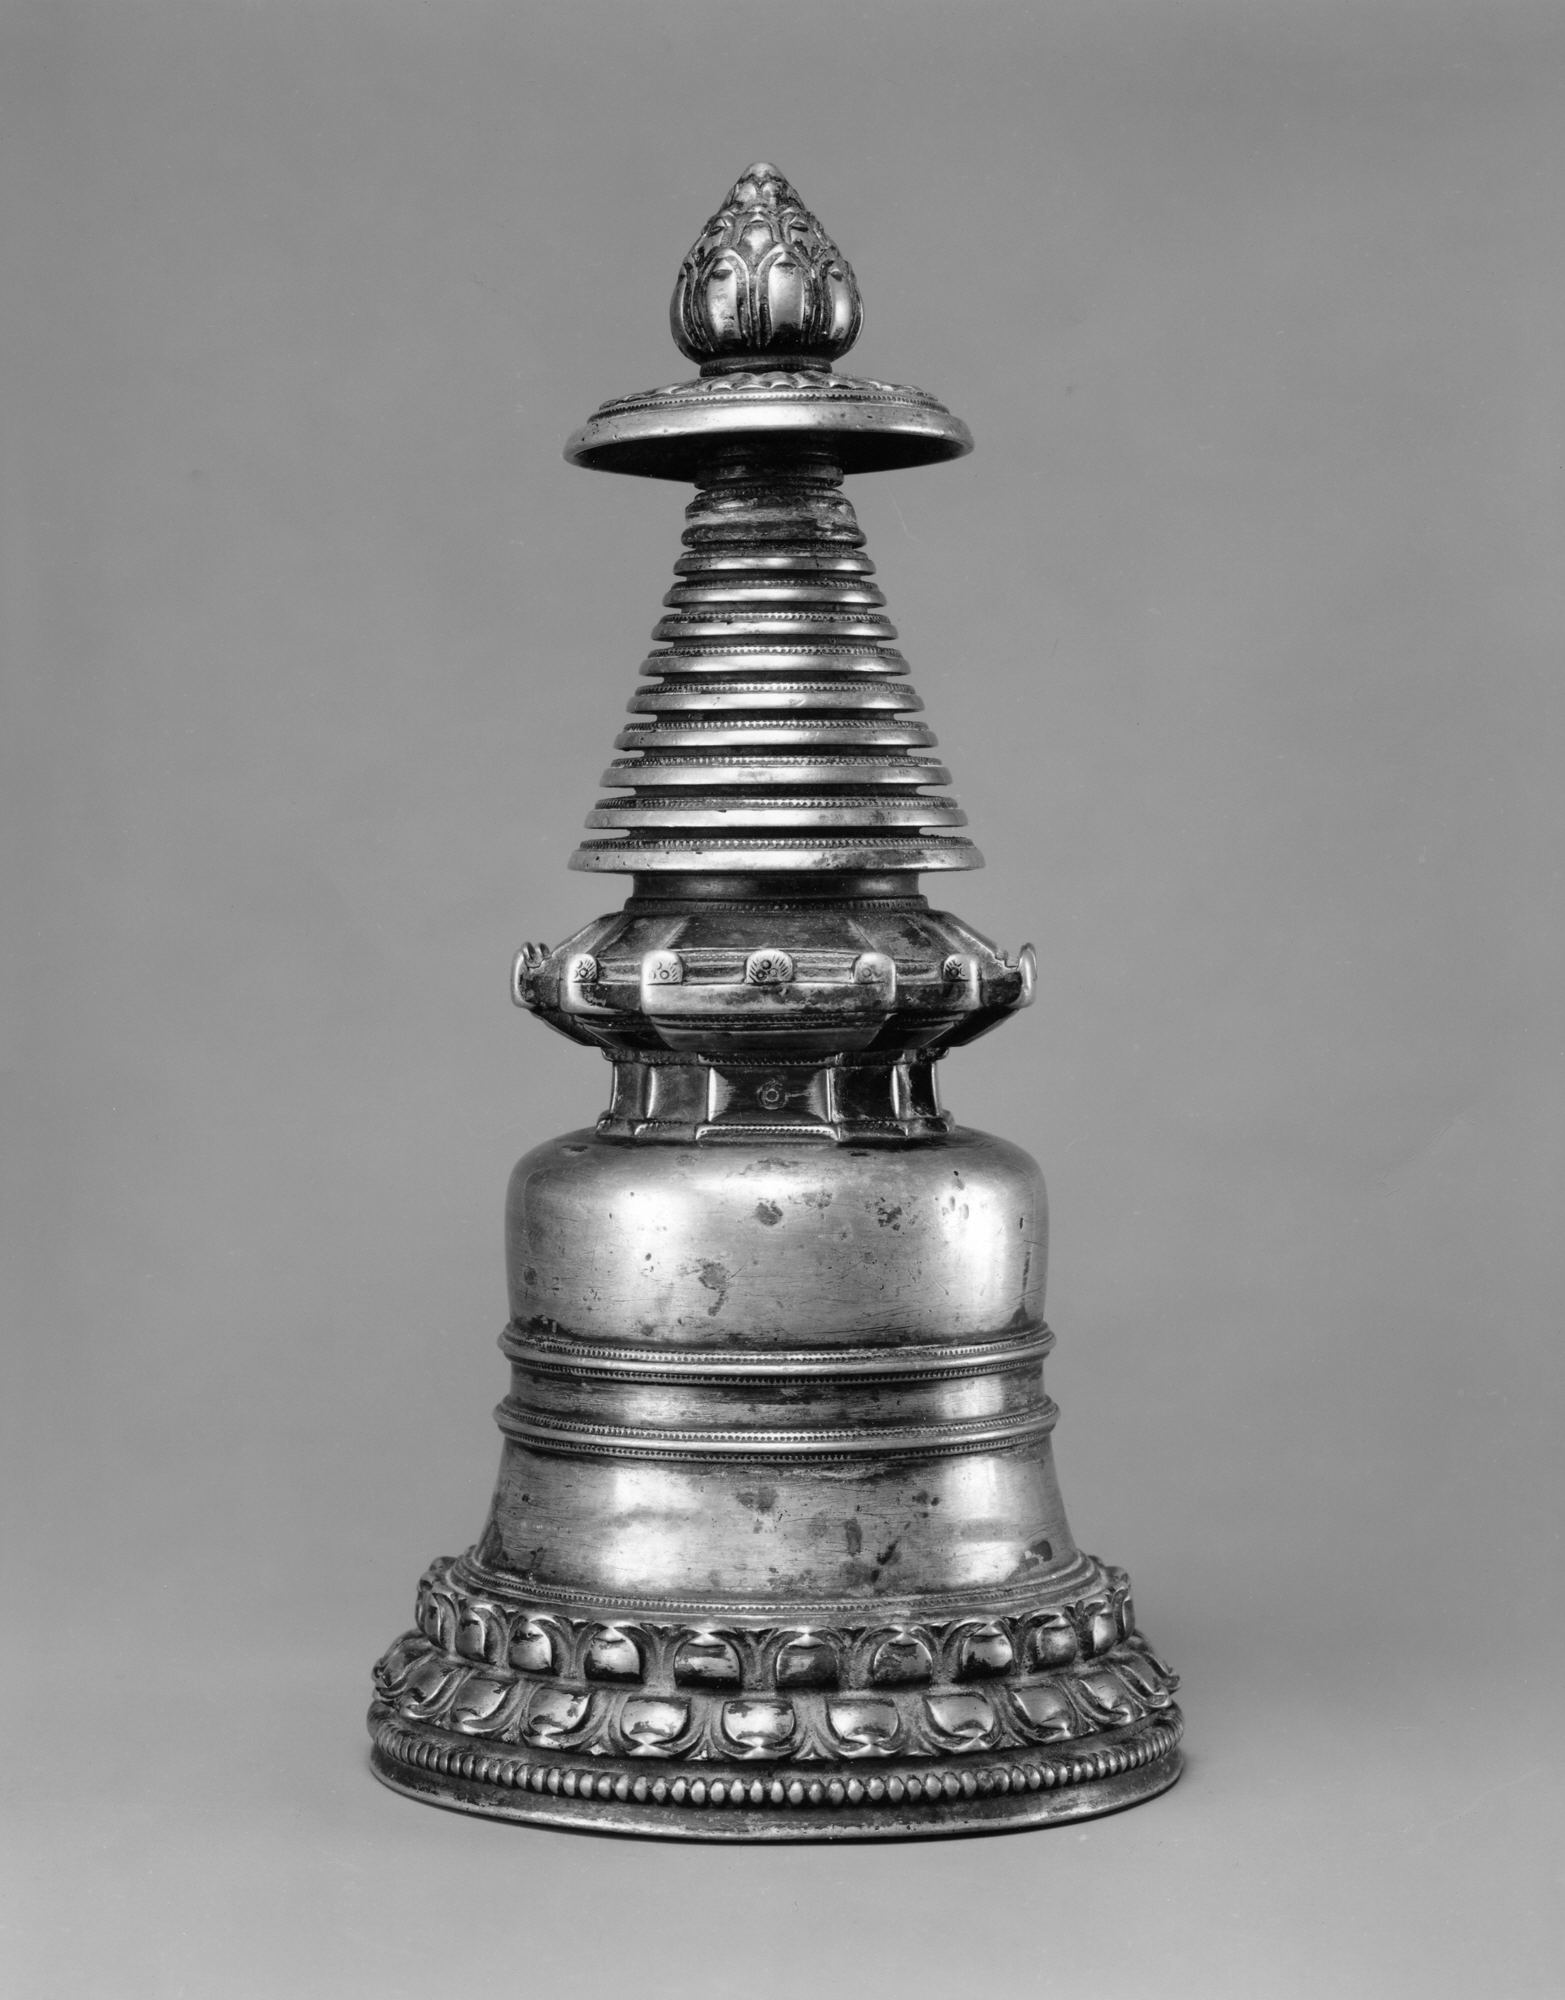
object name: stupa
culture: tibetan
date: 1201-1300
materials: brass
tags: stupas